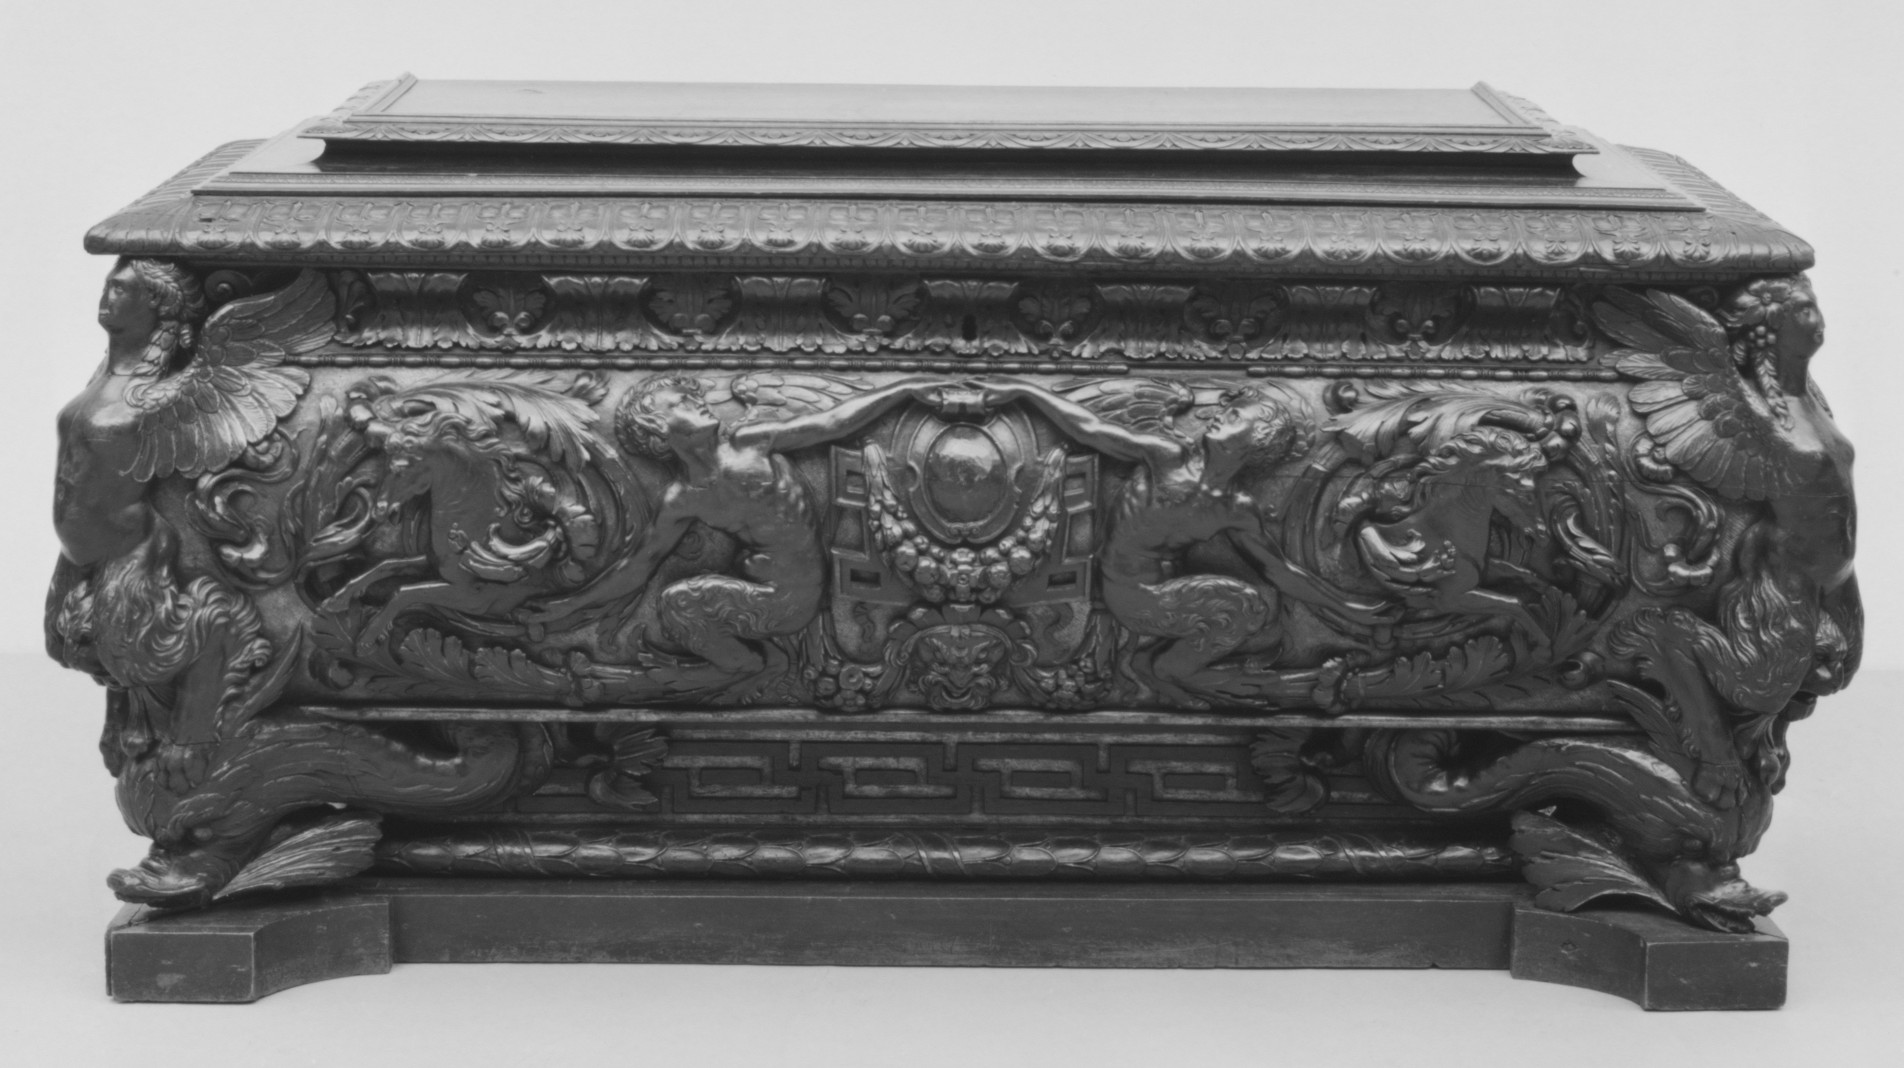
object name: cassone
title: Cassone (one of a pair)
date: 1551-1600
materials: wood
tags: satyrs,horses